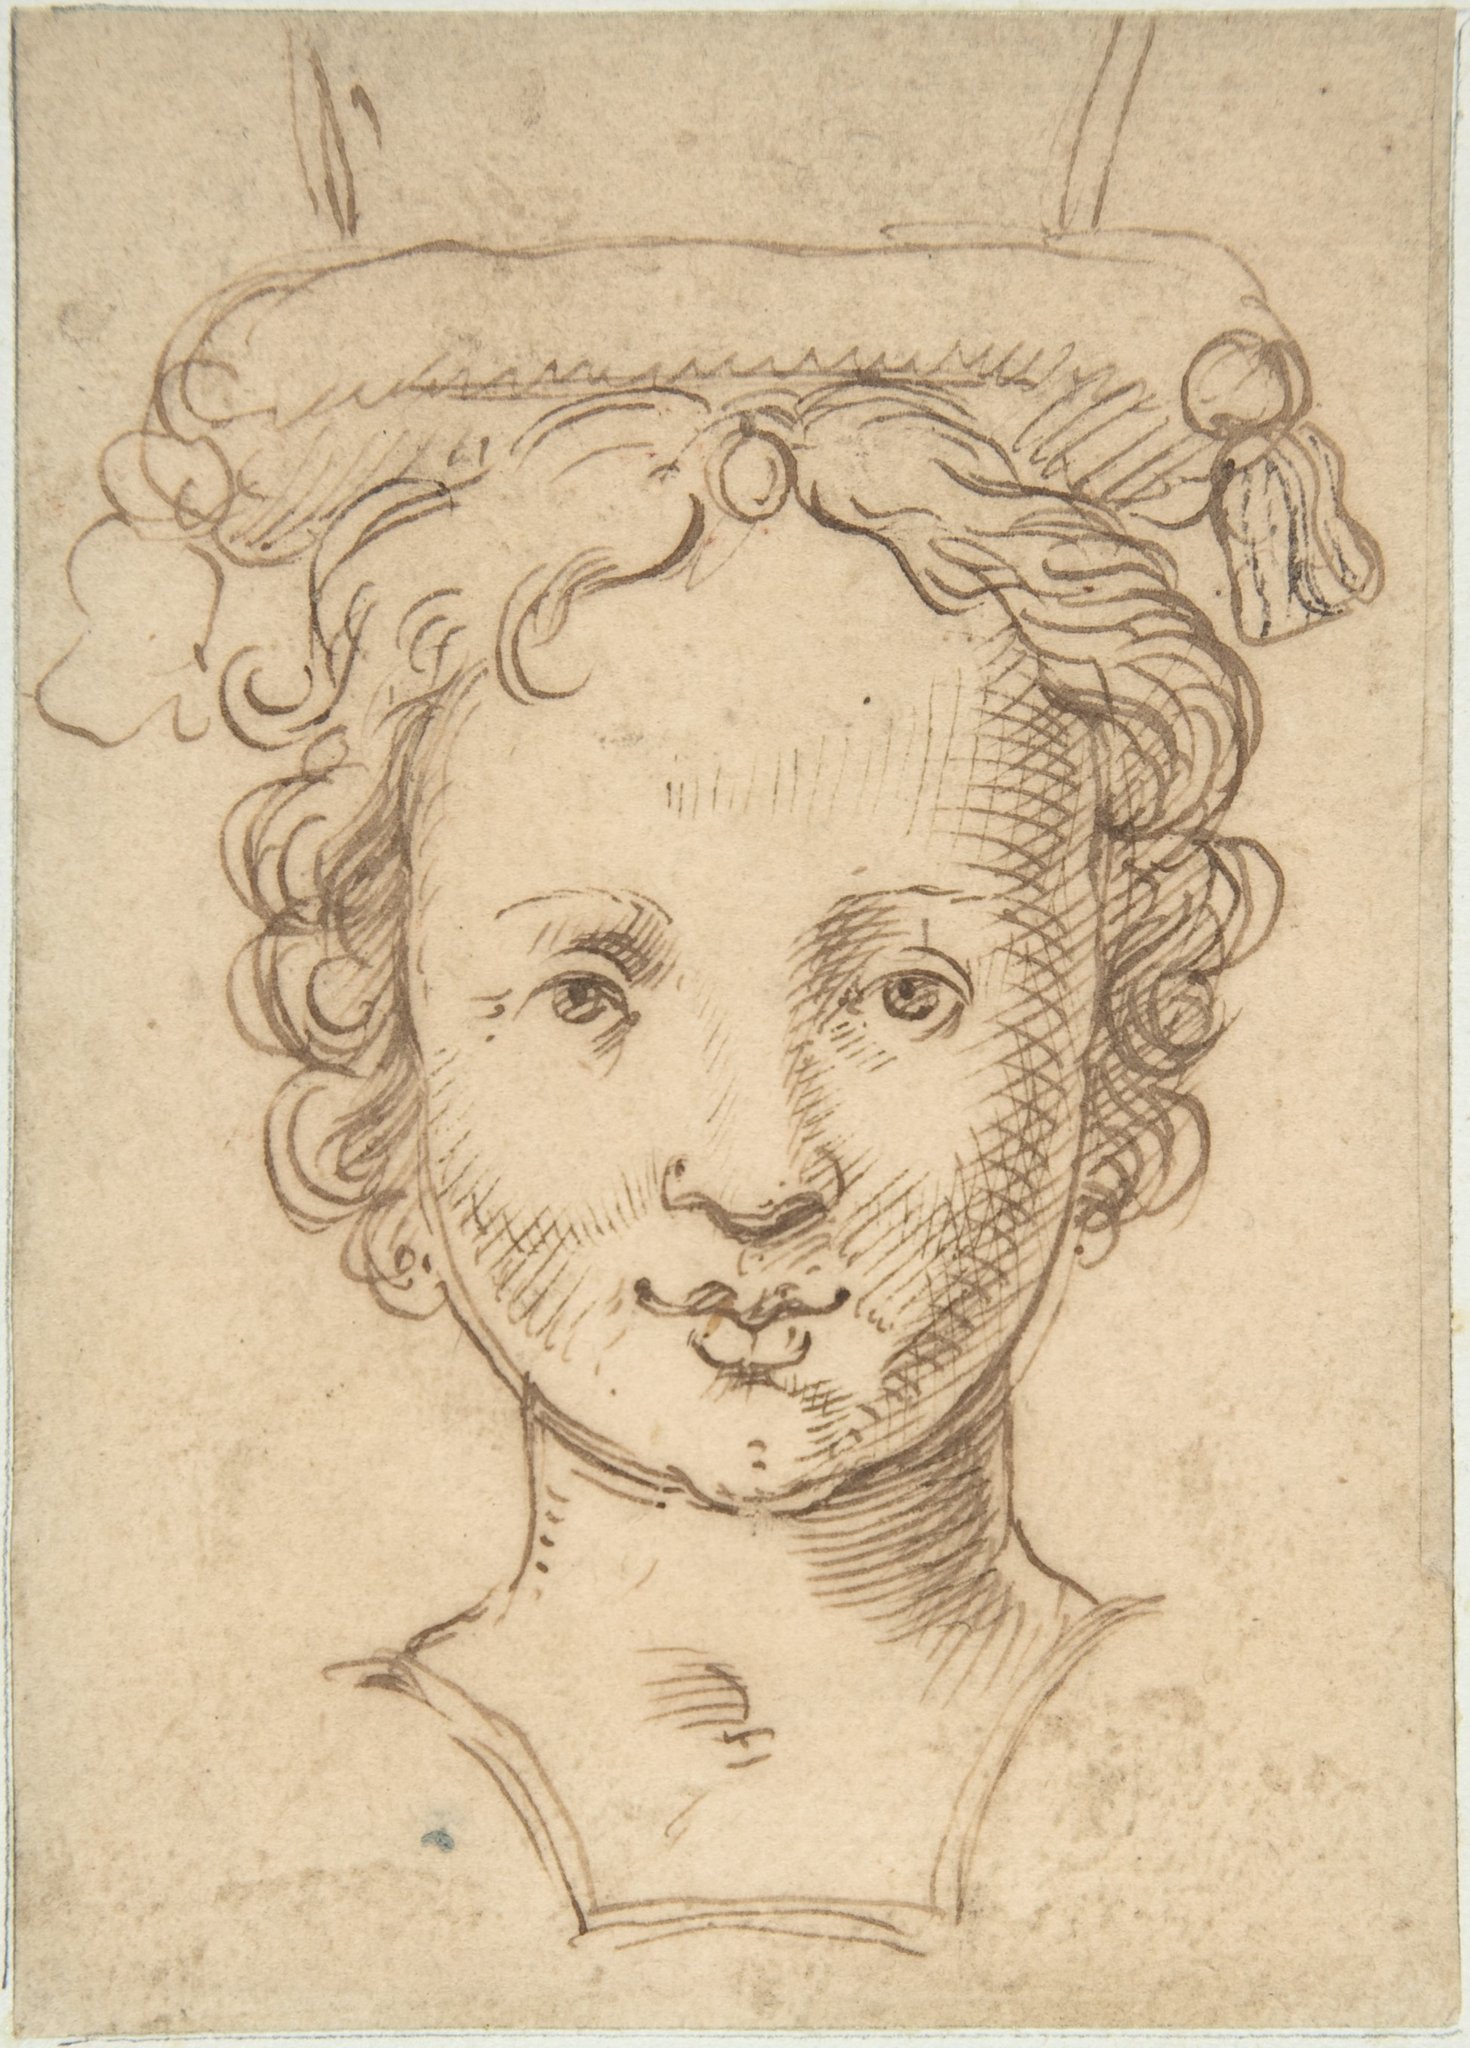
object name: drawing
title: Head of a Young Woman, a Probable Finial for Fountain or other Type of Waterwork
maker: anonymous, italian, sienese or marchigian, 16th century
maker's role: artist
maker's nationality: italian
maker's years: 1500-1600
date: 1501-1600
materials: ink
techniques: pen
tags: heads,women